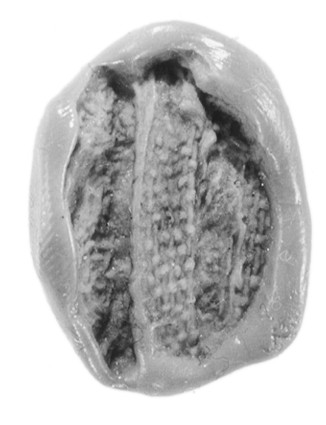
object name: sealing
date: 2030-1640 BCE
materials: clay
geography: egypt